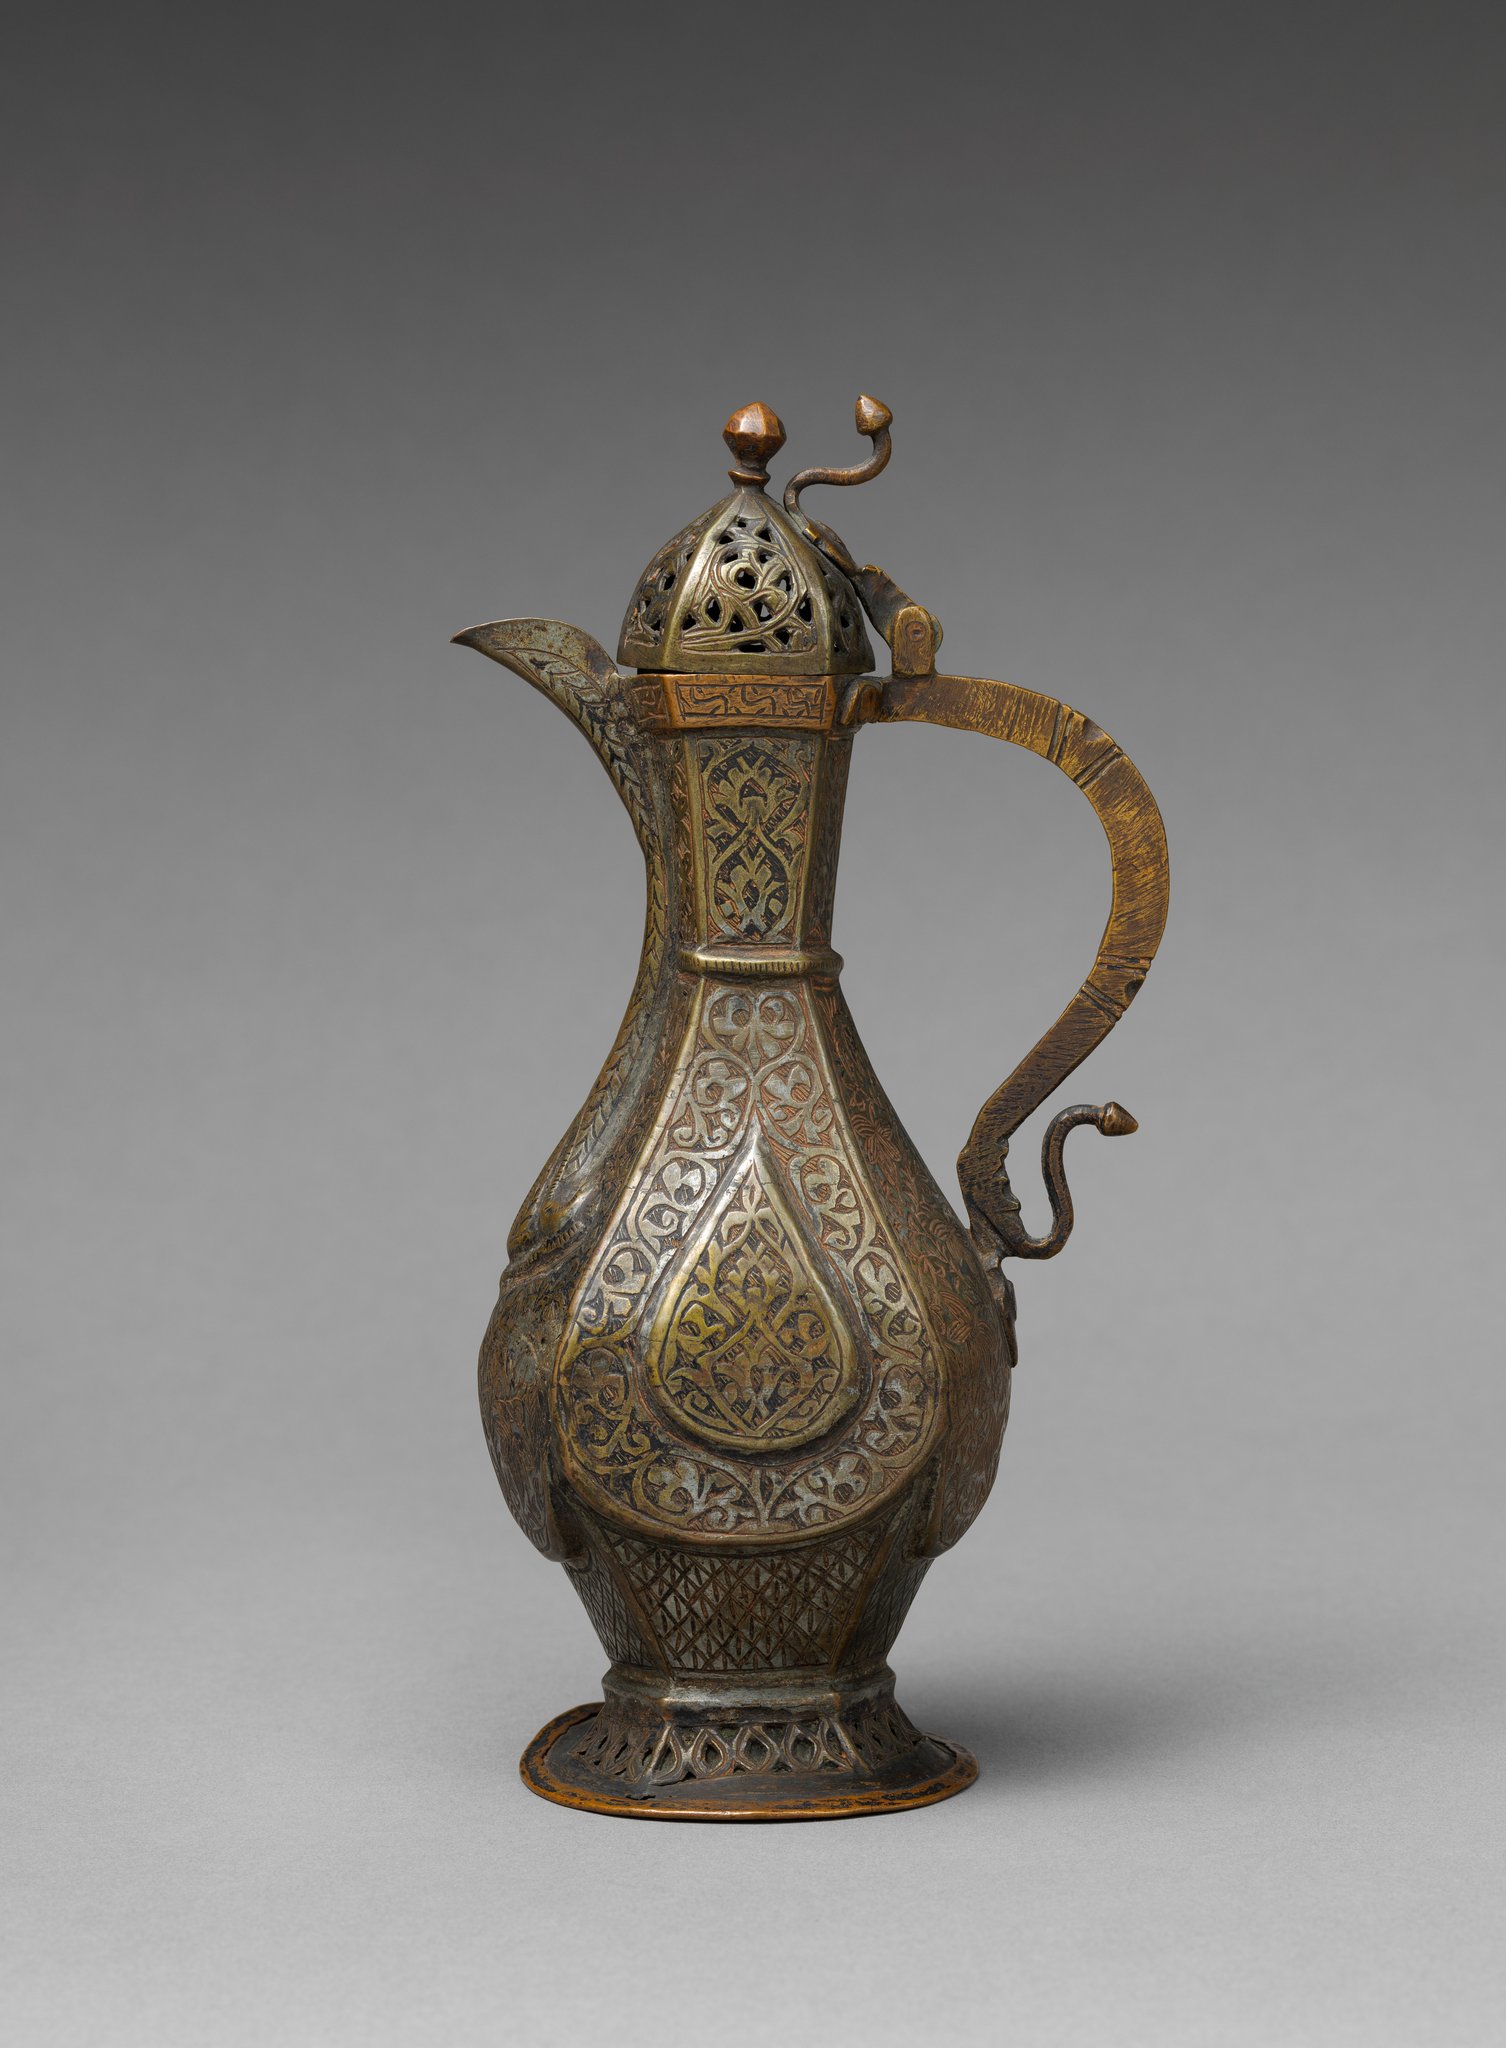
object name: coffee pot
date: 1801-1900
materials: copper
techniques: chasing, embossing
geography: china